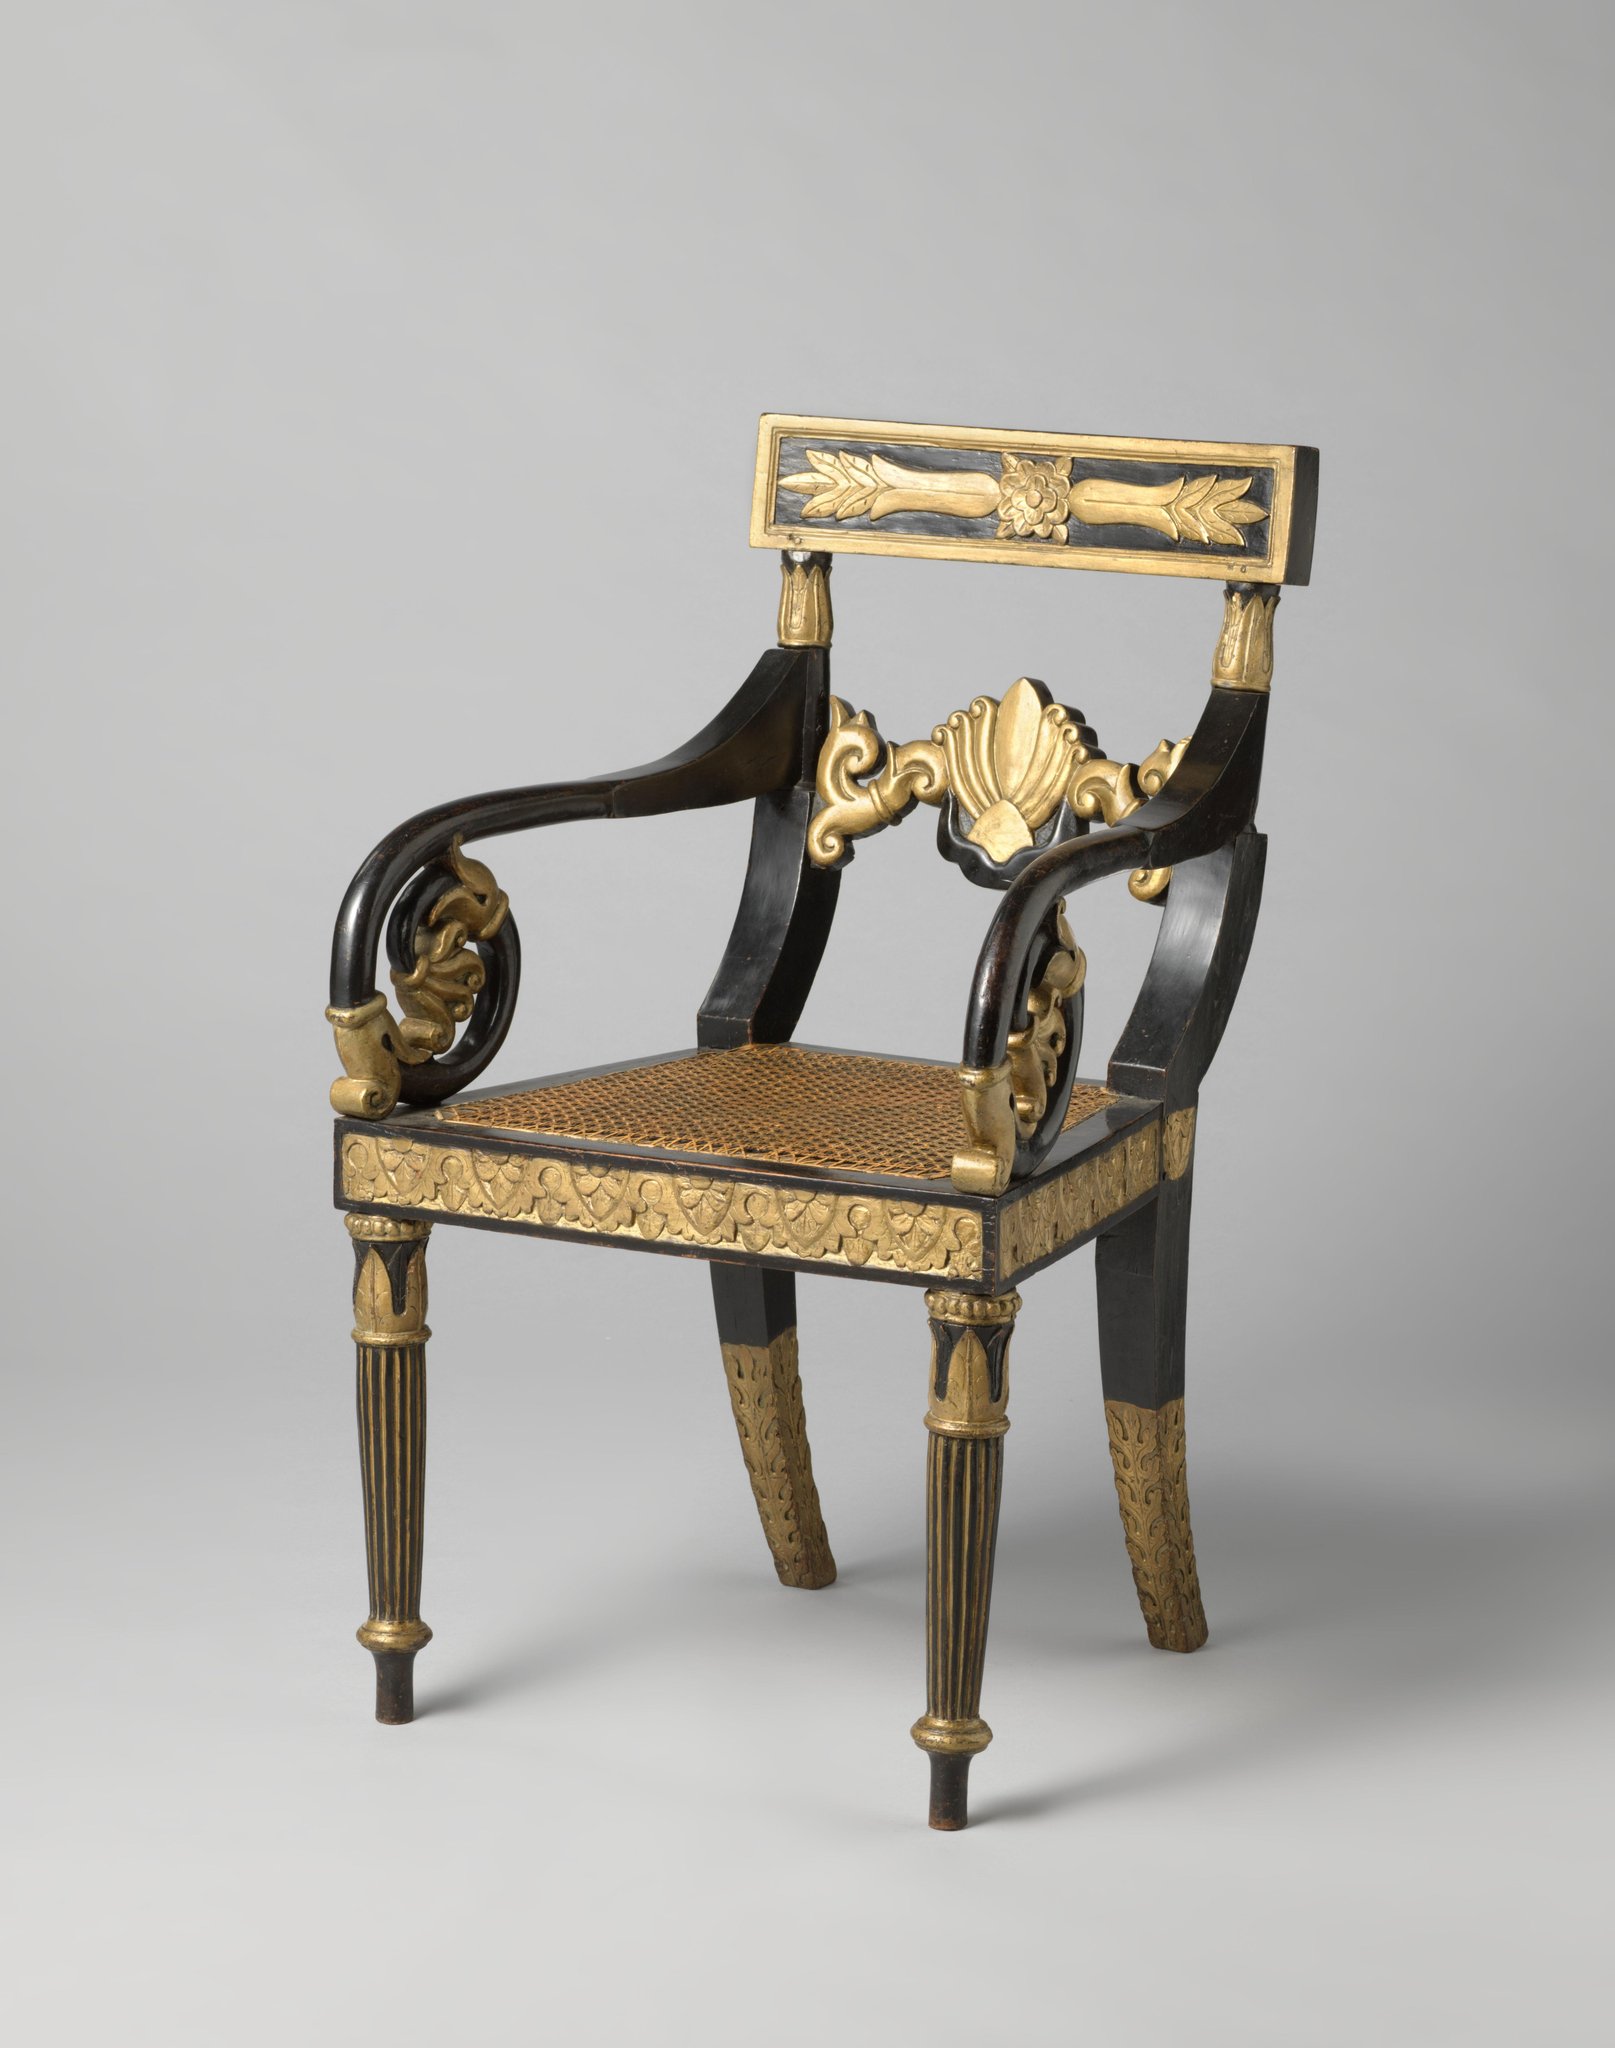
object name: chair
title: Armstoel, zwart gelakt en met verguld beeldhouwwerk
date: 1825-1850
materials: wood, rattan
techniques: transfer printed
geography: indonesia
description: Armstoel met gecanneleerde voorpoten en sabelvormige achterpoten, een rechte leuningskap en armleuningen die aan de voorzijde grote voluten vormen. Zwart gelakt en met verguld beeldhouwwerk. Naar een ontwerp uit Ackerman's Repository of Arts van 1828.